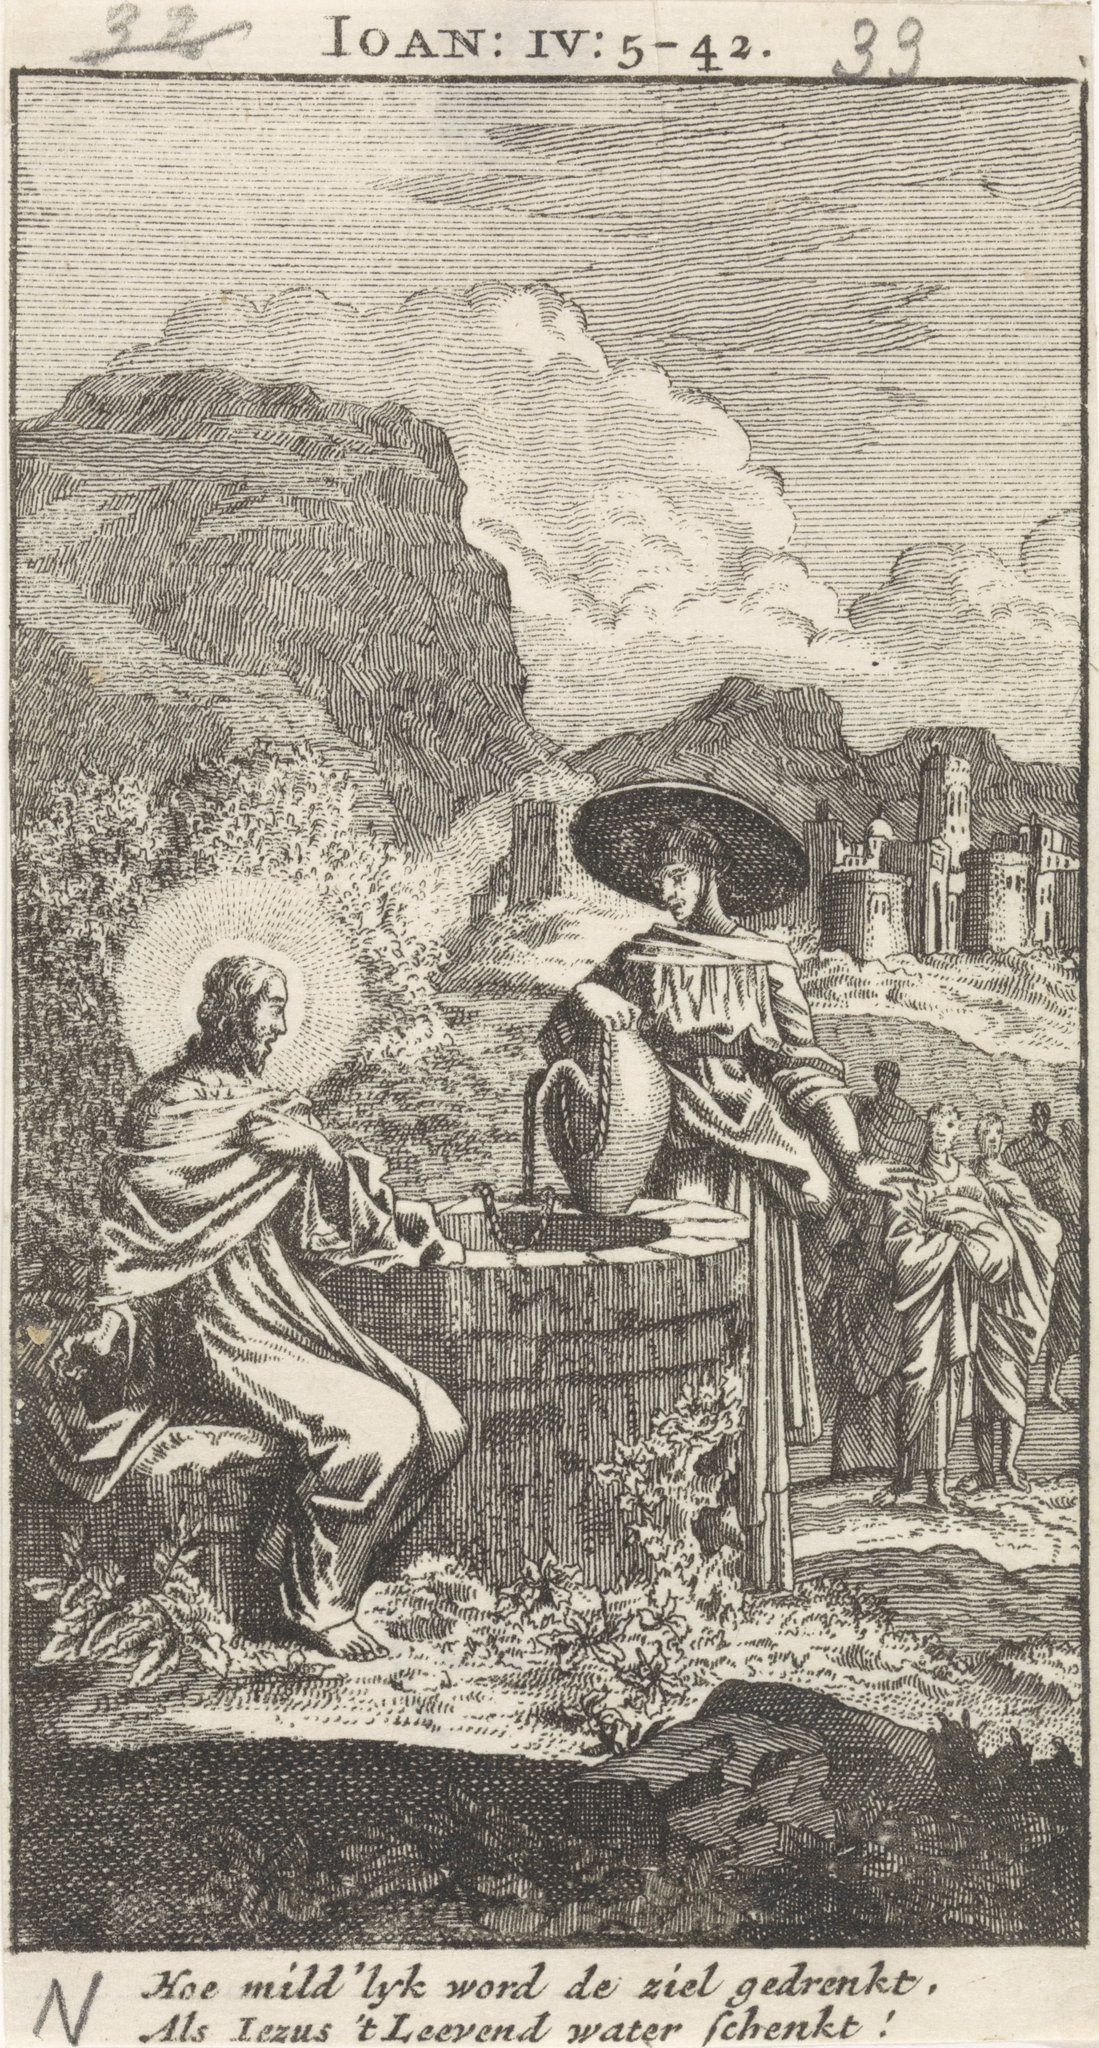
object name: print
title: Christus en de Samaritaanse vrouw bij de put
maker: Anonymous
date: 1712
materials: paper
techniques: etching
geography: amsterdam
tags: well, christ and the woman of samaria: sitting at jacob's well he asks her for a drink from her jug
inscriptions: collector's mark: Lugt 2228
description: Kopie van illustratie voor: Luyken, Jan. Bybel printen. Amsterdam: Pieter Arentsz. II (wed.) en Cornelis van der Sys, 1712, p. 32.